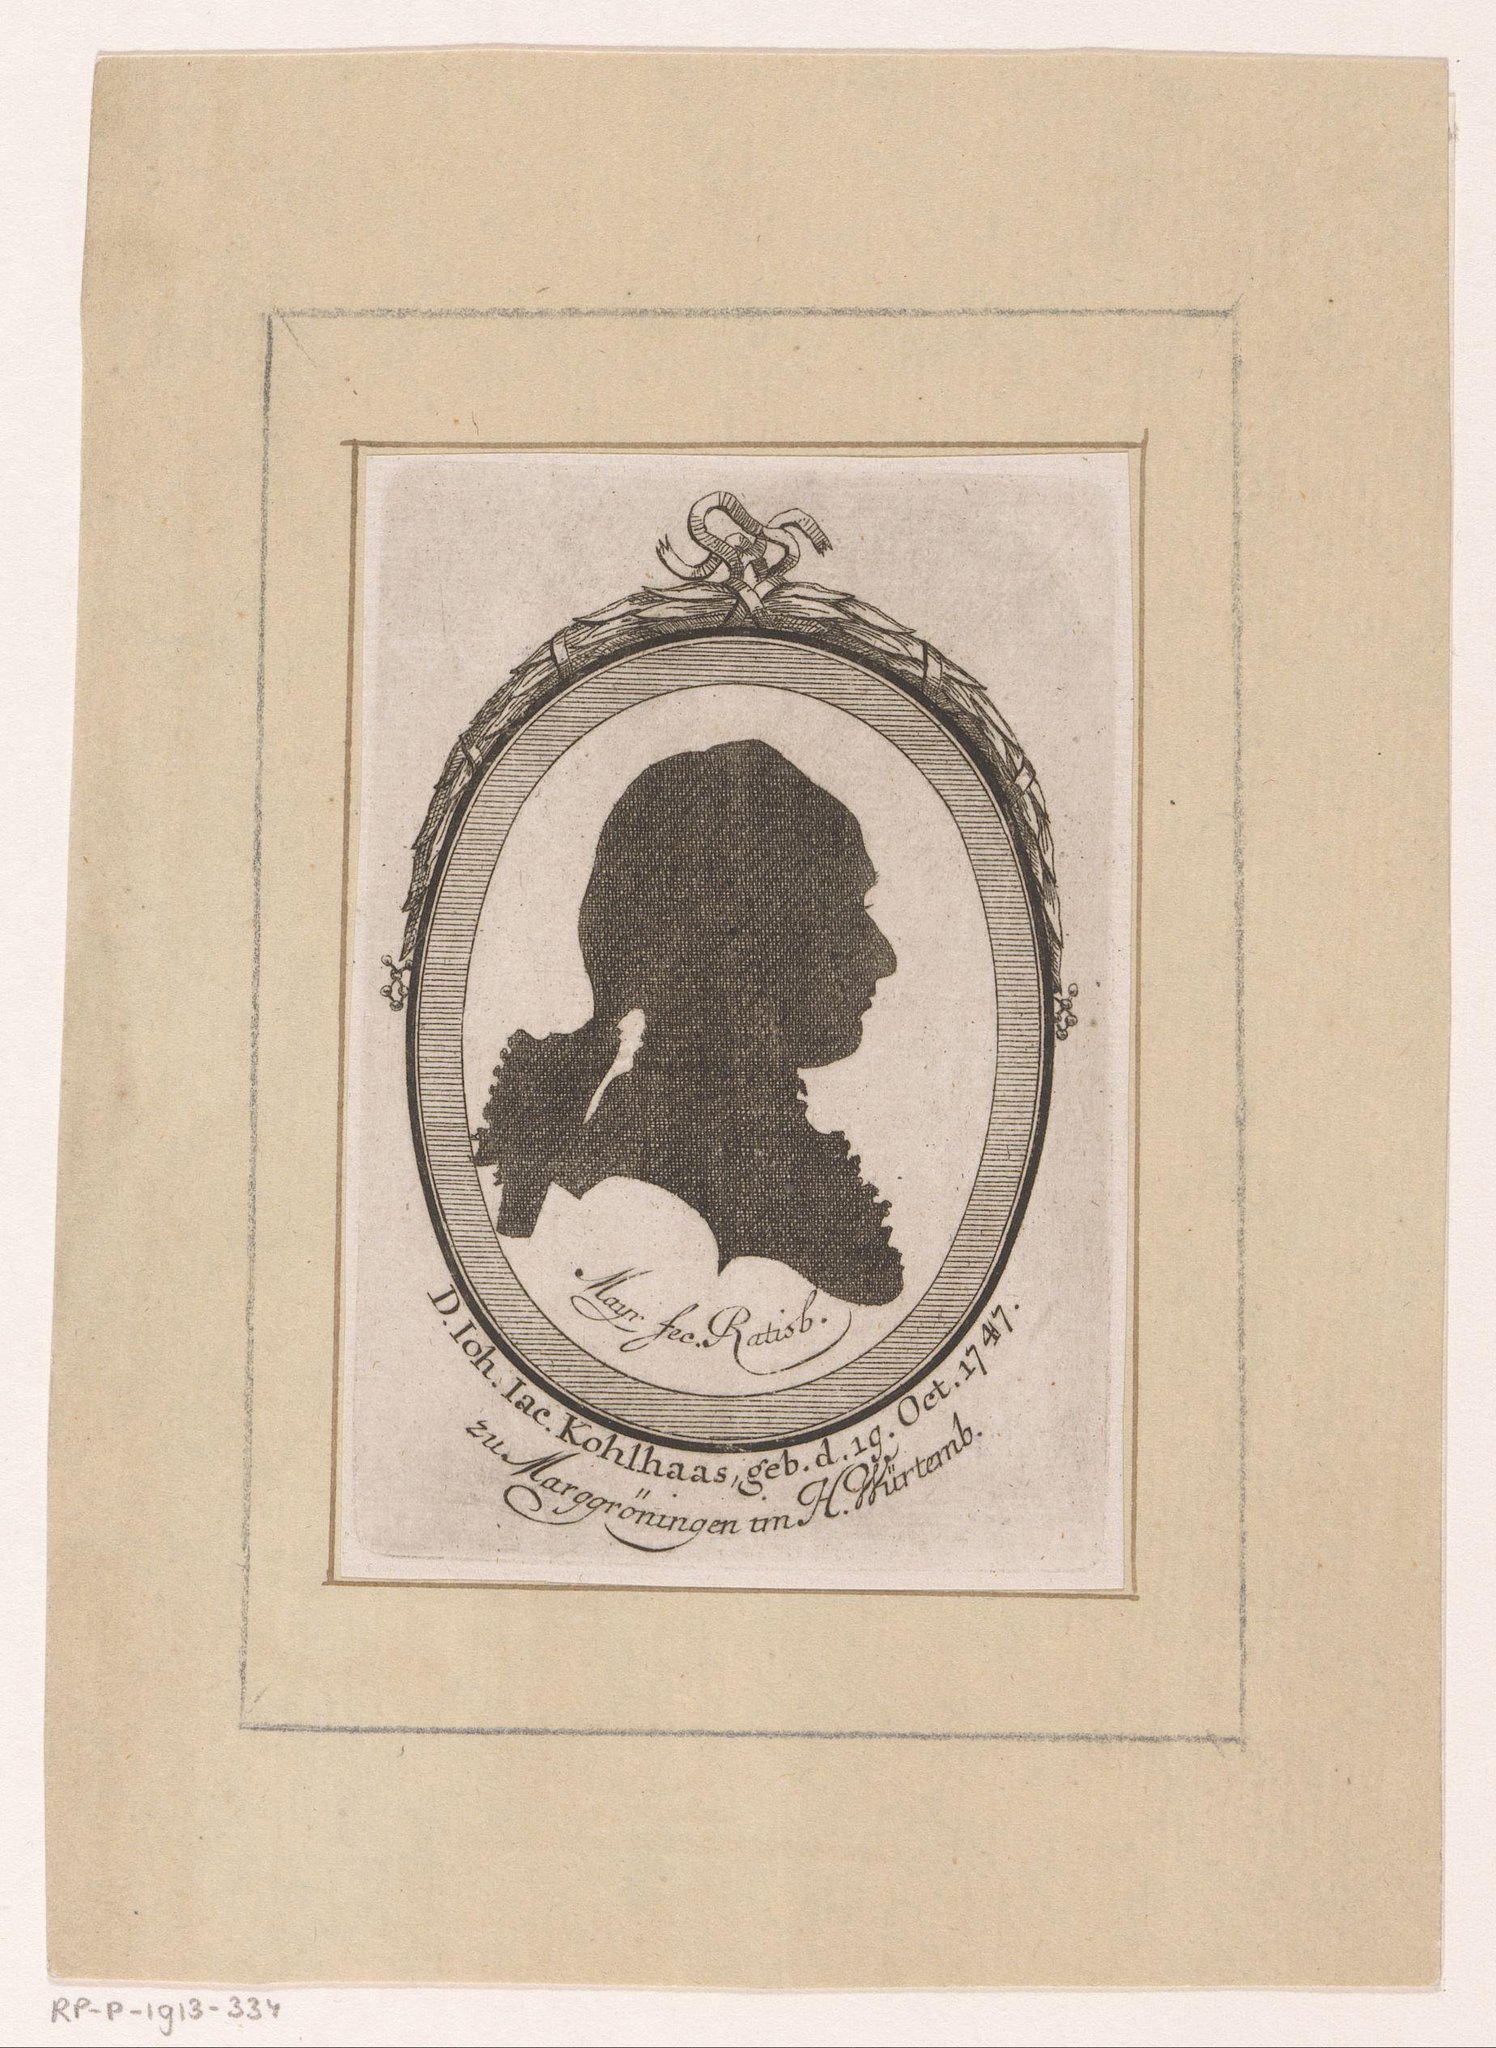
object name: print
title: Portret van Johann Jacob Kohlhaas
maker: johann mayr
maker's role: print maker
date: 1780-1809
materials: paper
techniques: etching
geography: regensburg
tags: historical persons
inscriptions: collector's mark: Lugt 2228